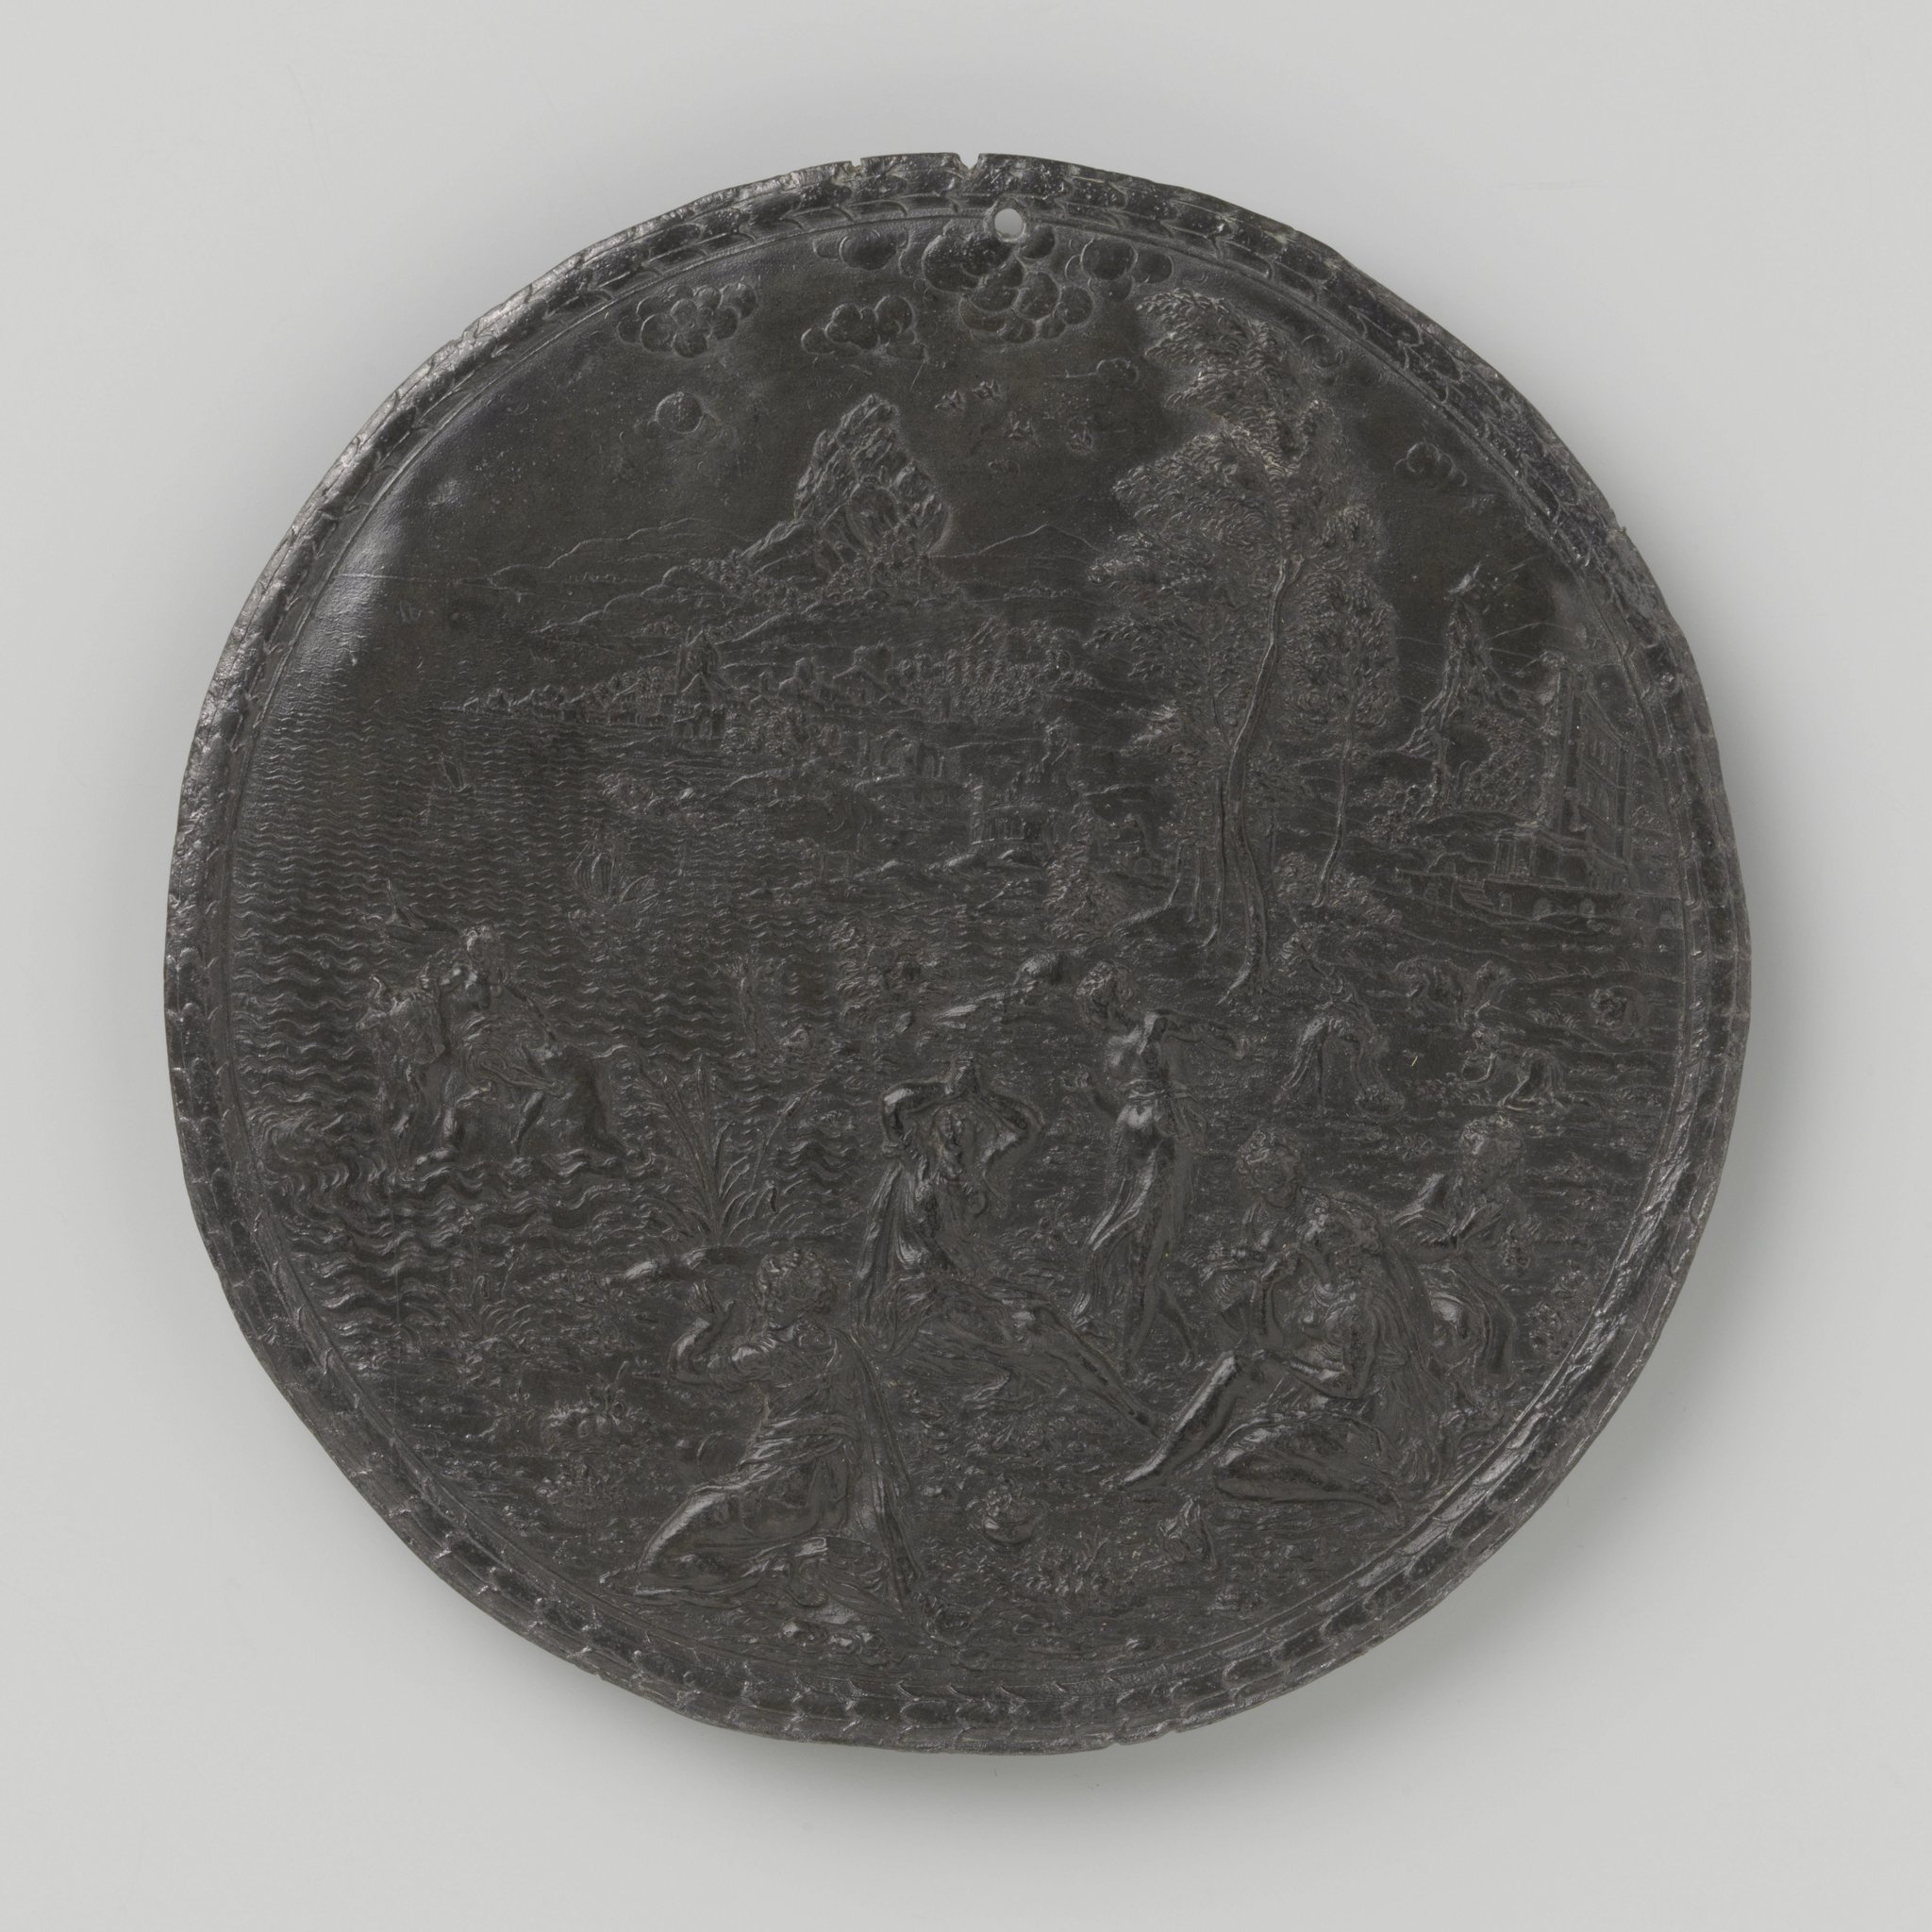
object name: plaque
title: De ontvoering van Europa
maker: paulus willemsz. van vianen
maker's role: draughtsman, jeweler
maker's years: 1570-1614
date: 1600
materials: lead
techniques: casting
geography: munich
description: Ronde, loden plaquette, omgeven door een bladkrans. Op de voorgrond een groep van zes kleine, gedrapeerde vrouwenfiguurtjes; links Jupiter, in de gedaante van een stier, die zich, met Europa op de rug, zwemmend van de oever verwijdert. Enige koeien en twee bloemenplukkende meisjesfiguren op het tweede plan. Een boomgroep, ruïnes en bergen op de achtergrond.